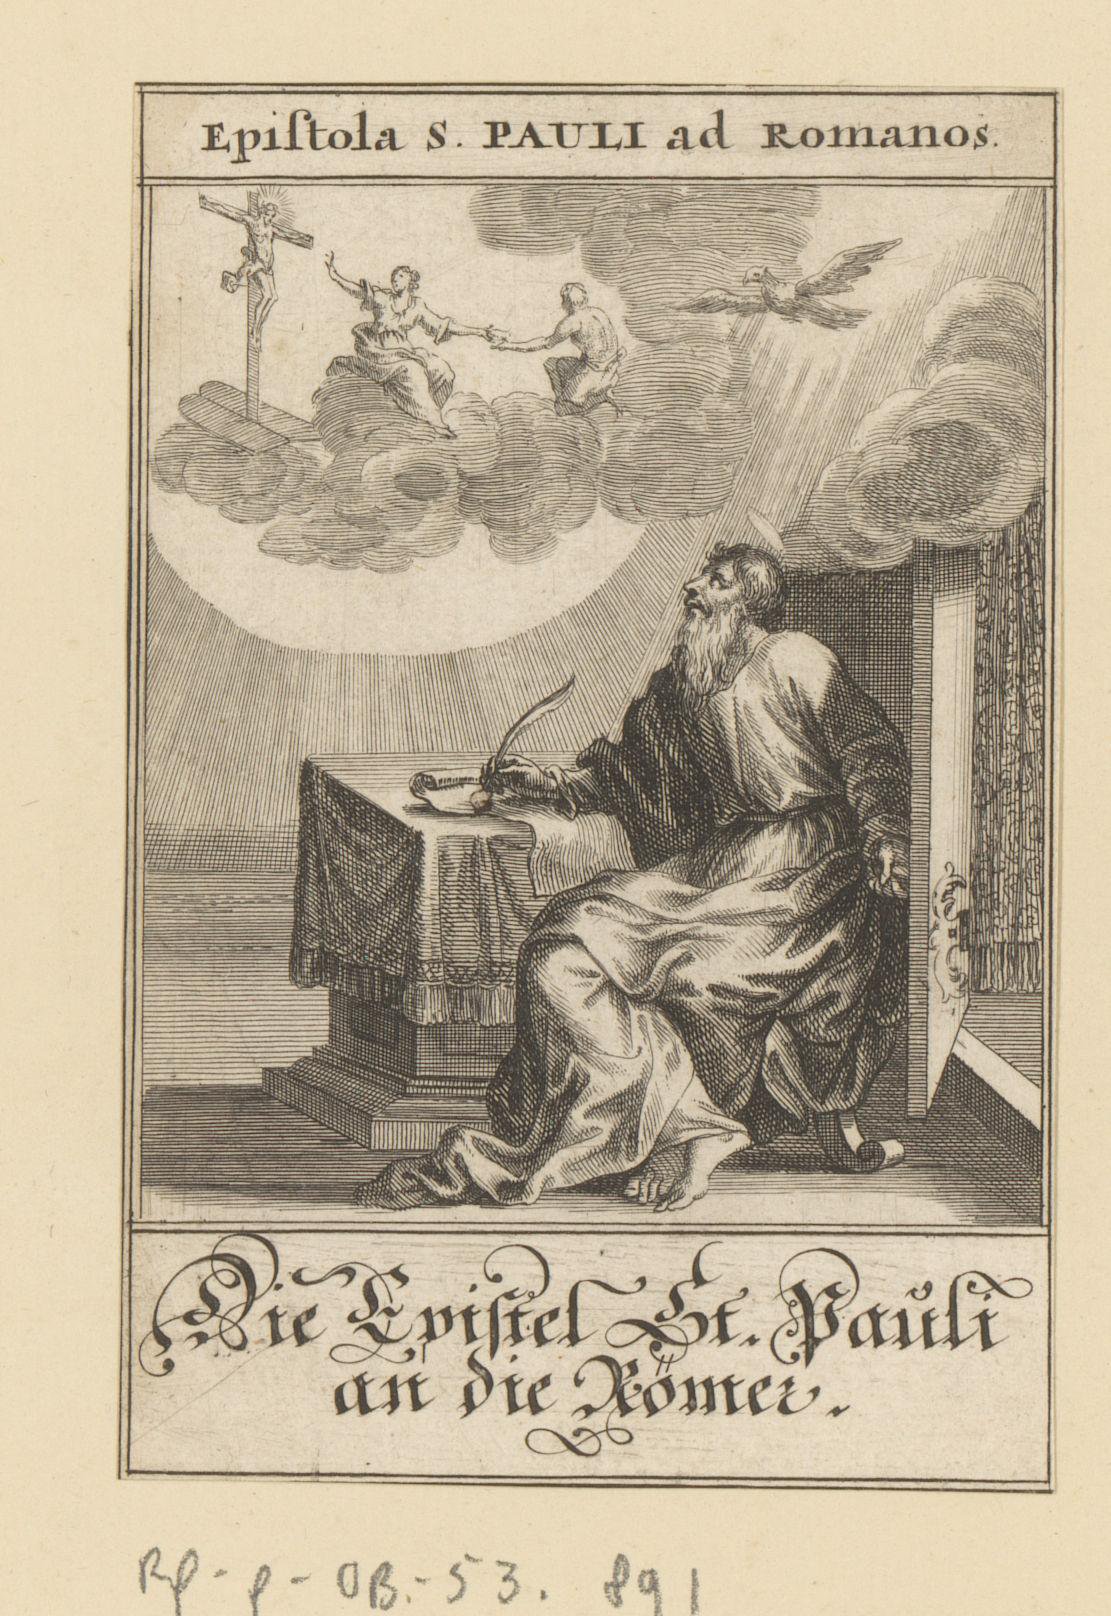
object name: print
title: Apostel Paulus schrijft zijn brief aan de Romeinen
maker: Anonymous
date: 1697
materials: paper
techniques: etching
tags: st. paul writing his epistles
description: Prent ook gebruikt in: Biblia ectypa : Bildnussen auss Heiliger Schrifft. Regensburg: Chr. Wiegel, 1697.